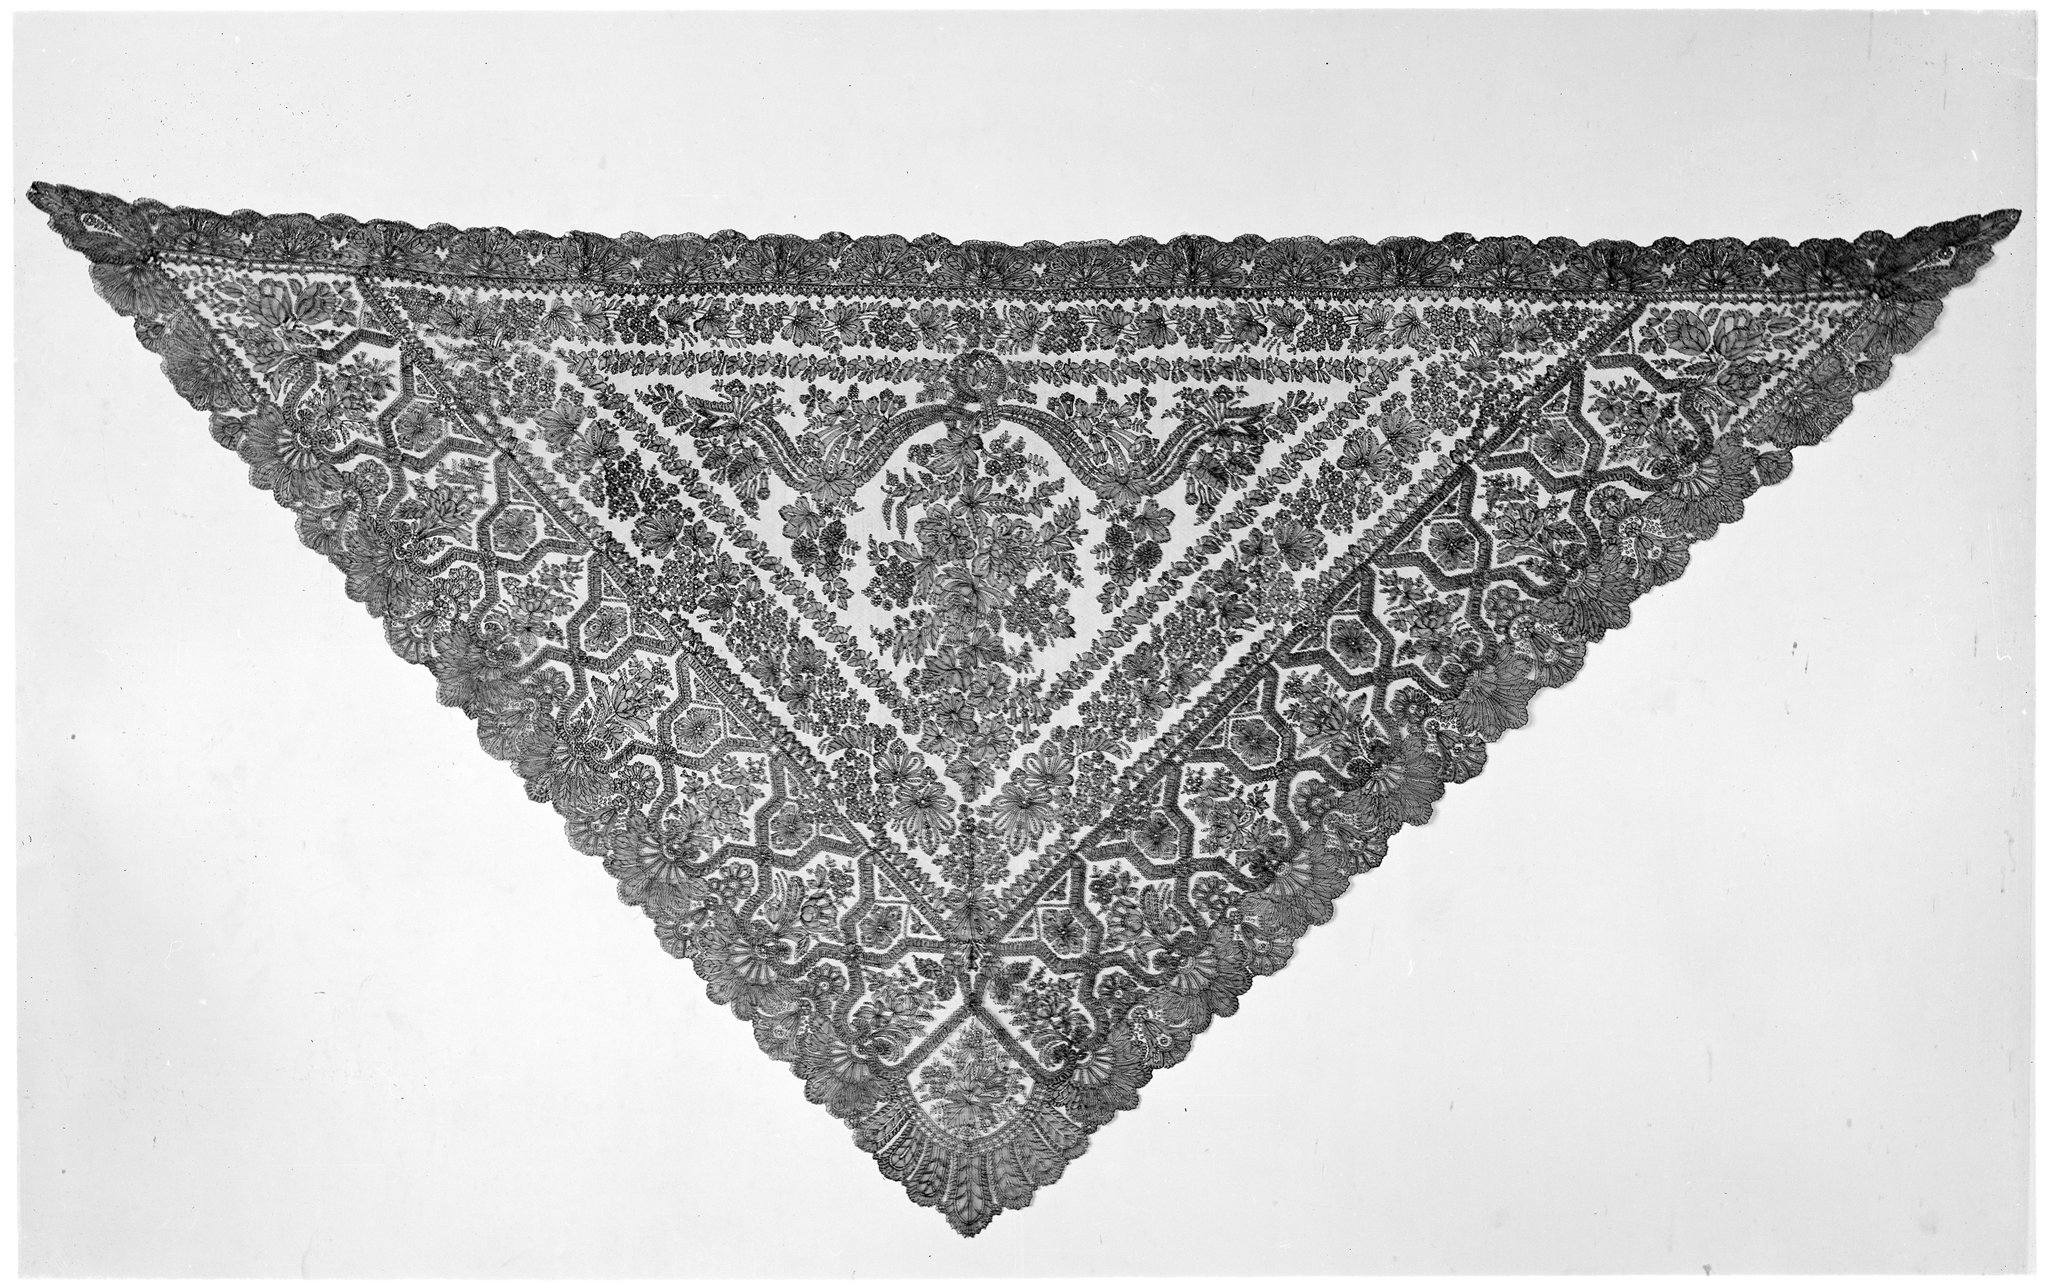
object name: shawl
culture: european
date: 1801-1900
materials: silk